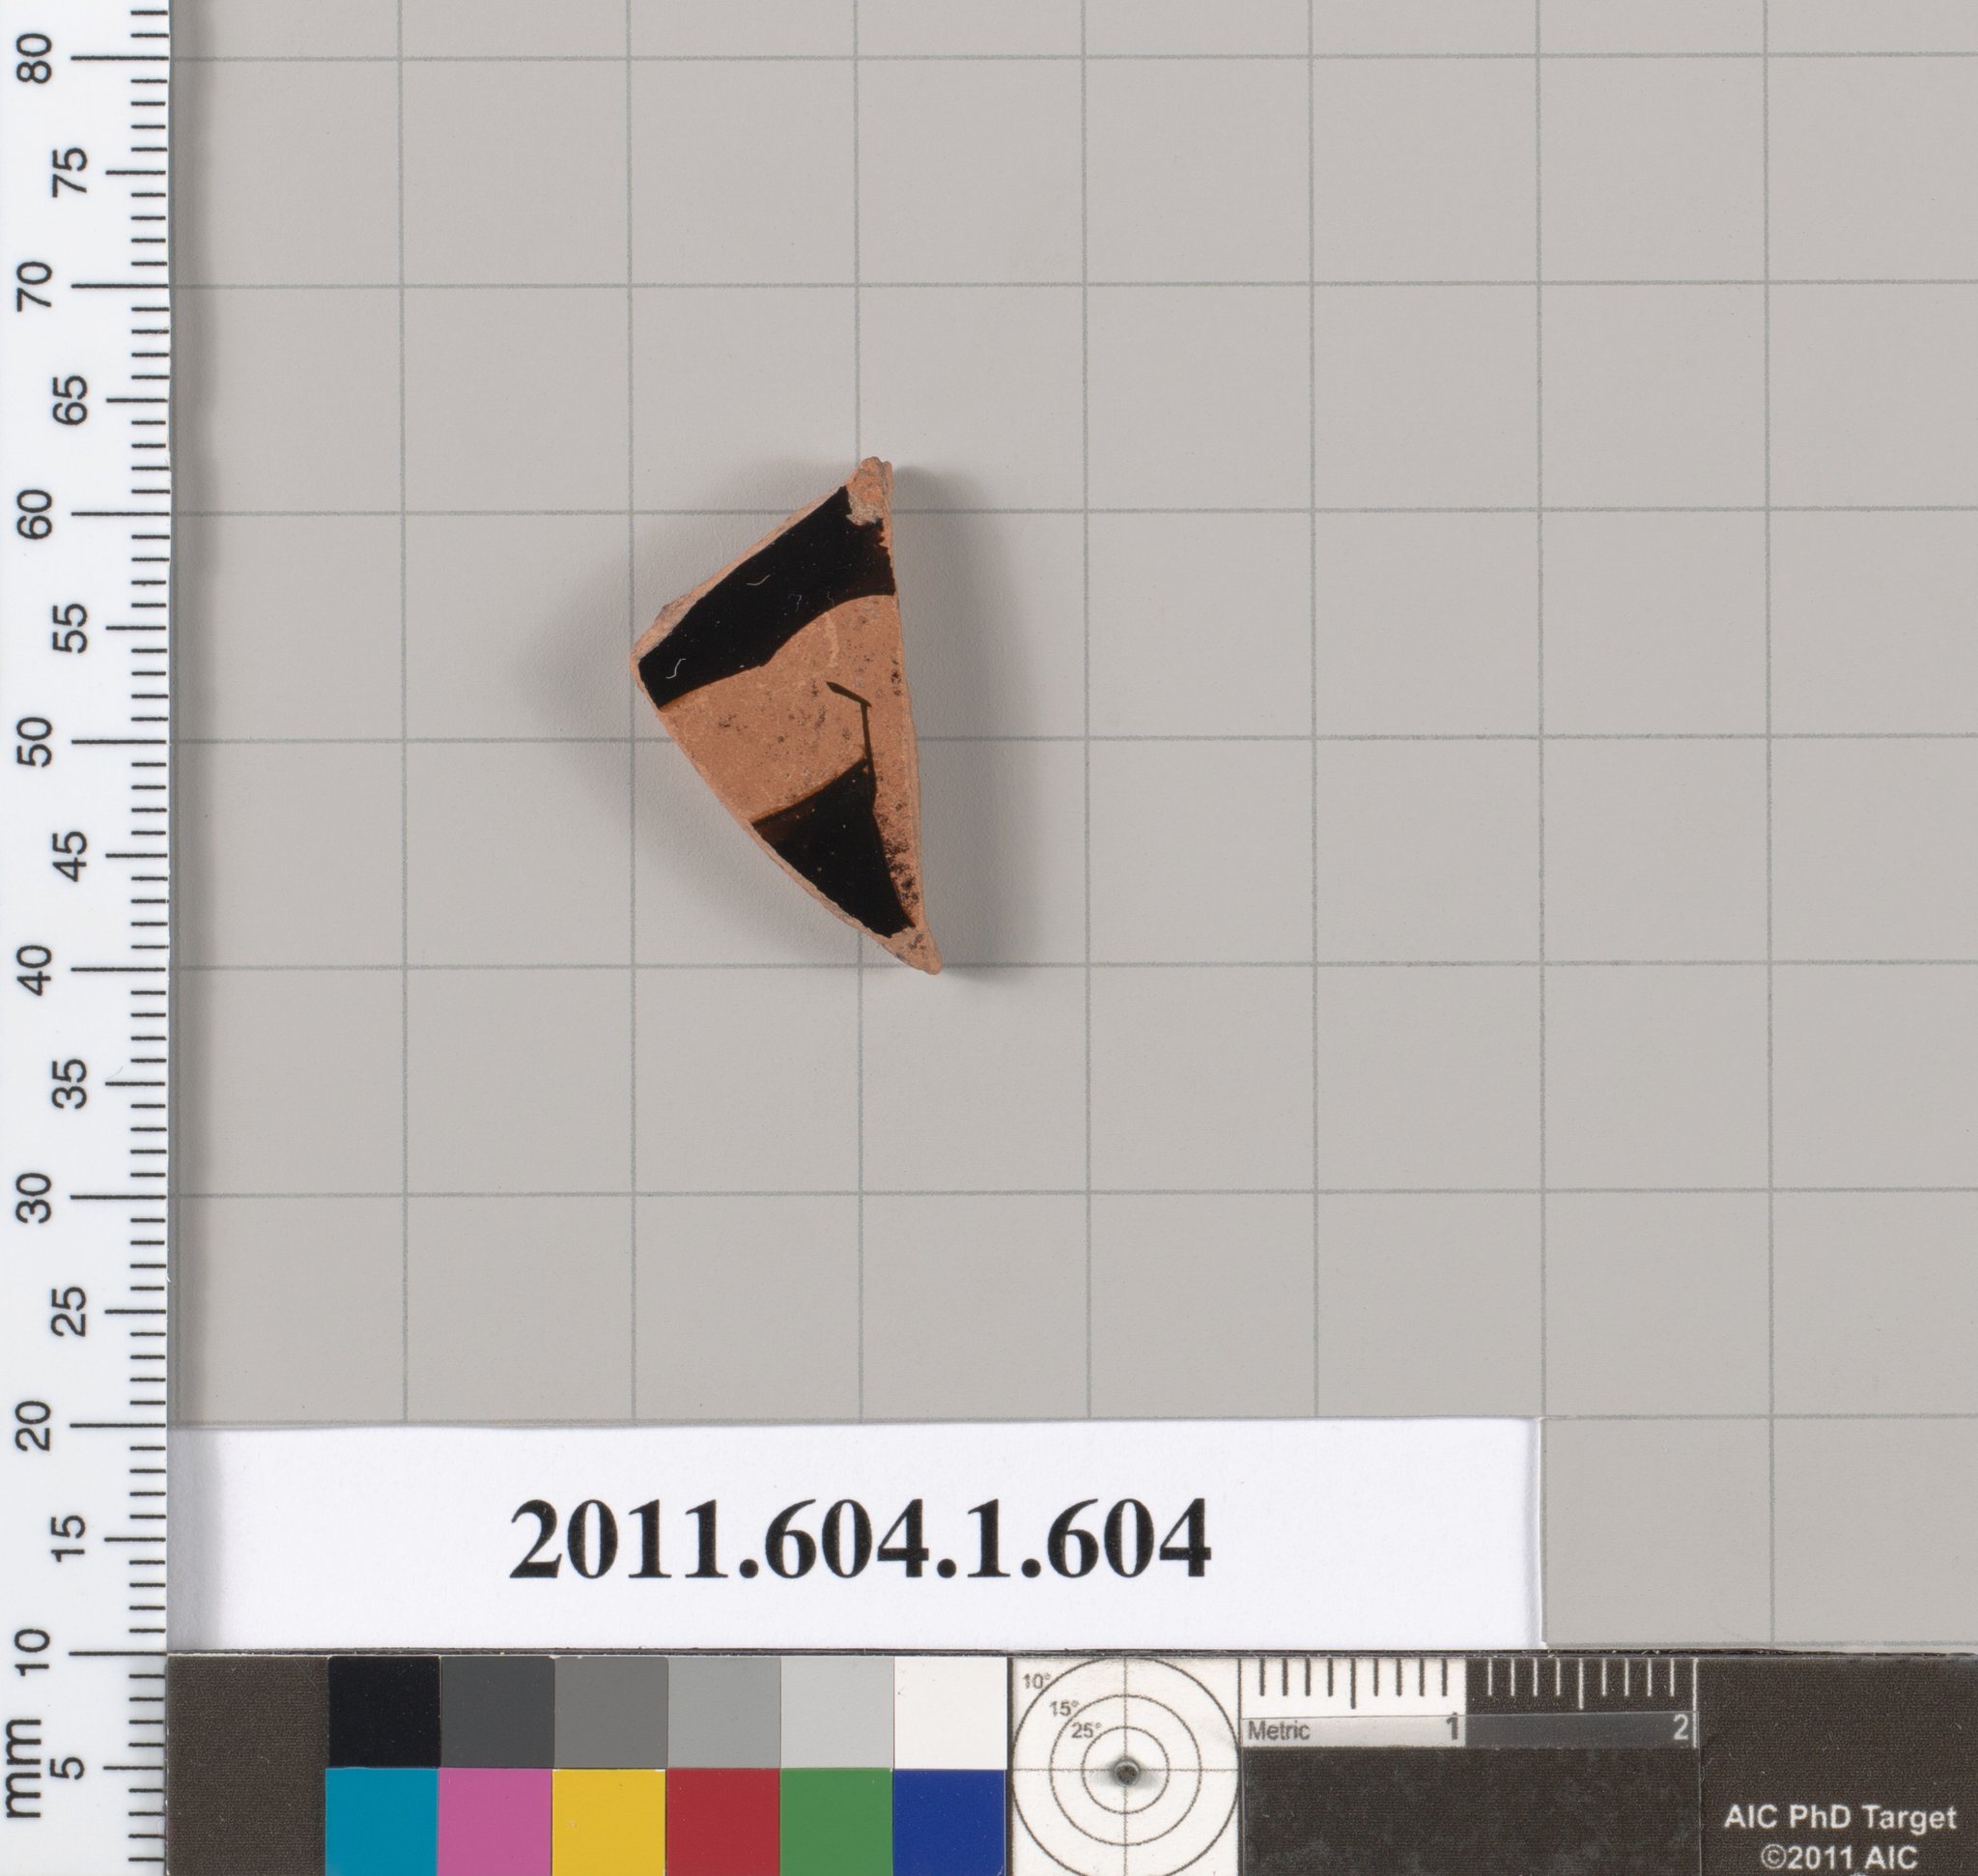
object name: kylix fragment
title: Terracotta fragment of a kylix (drinking cup)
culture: greek, attic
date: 475-451 BCE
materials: terracotta